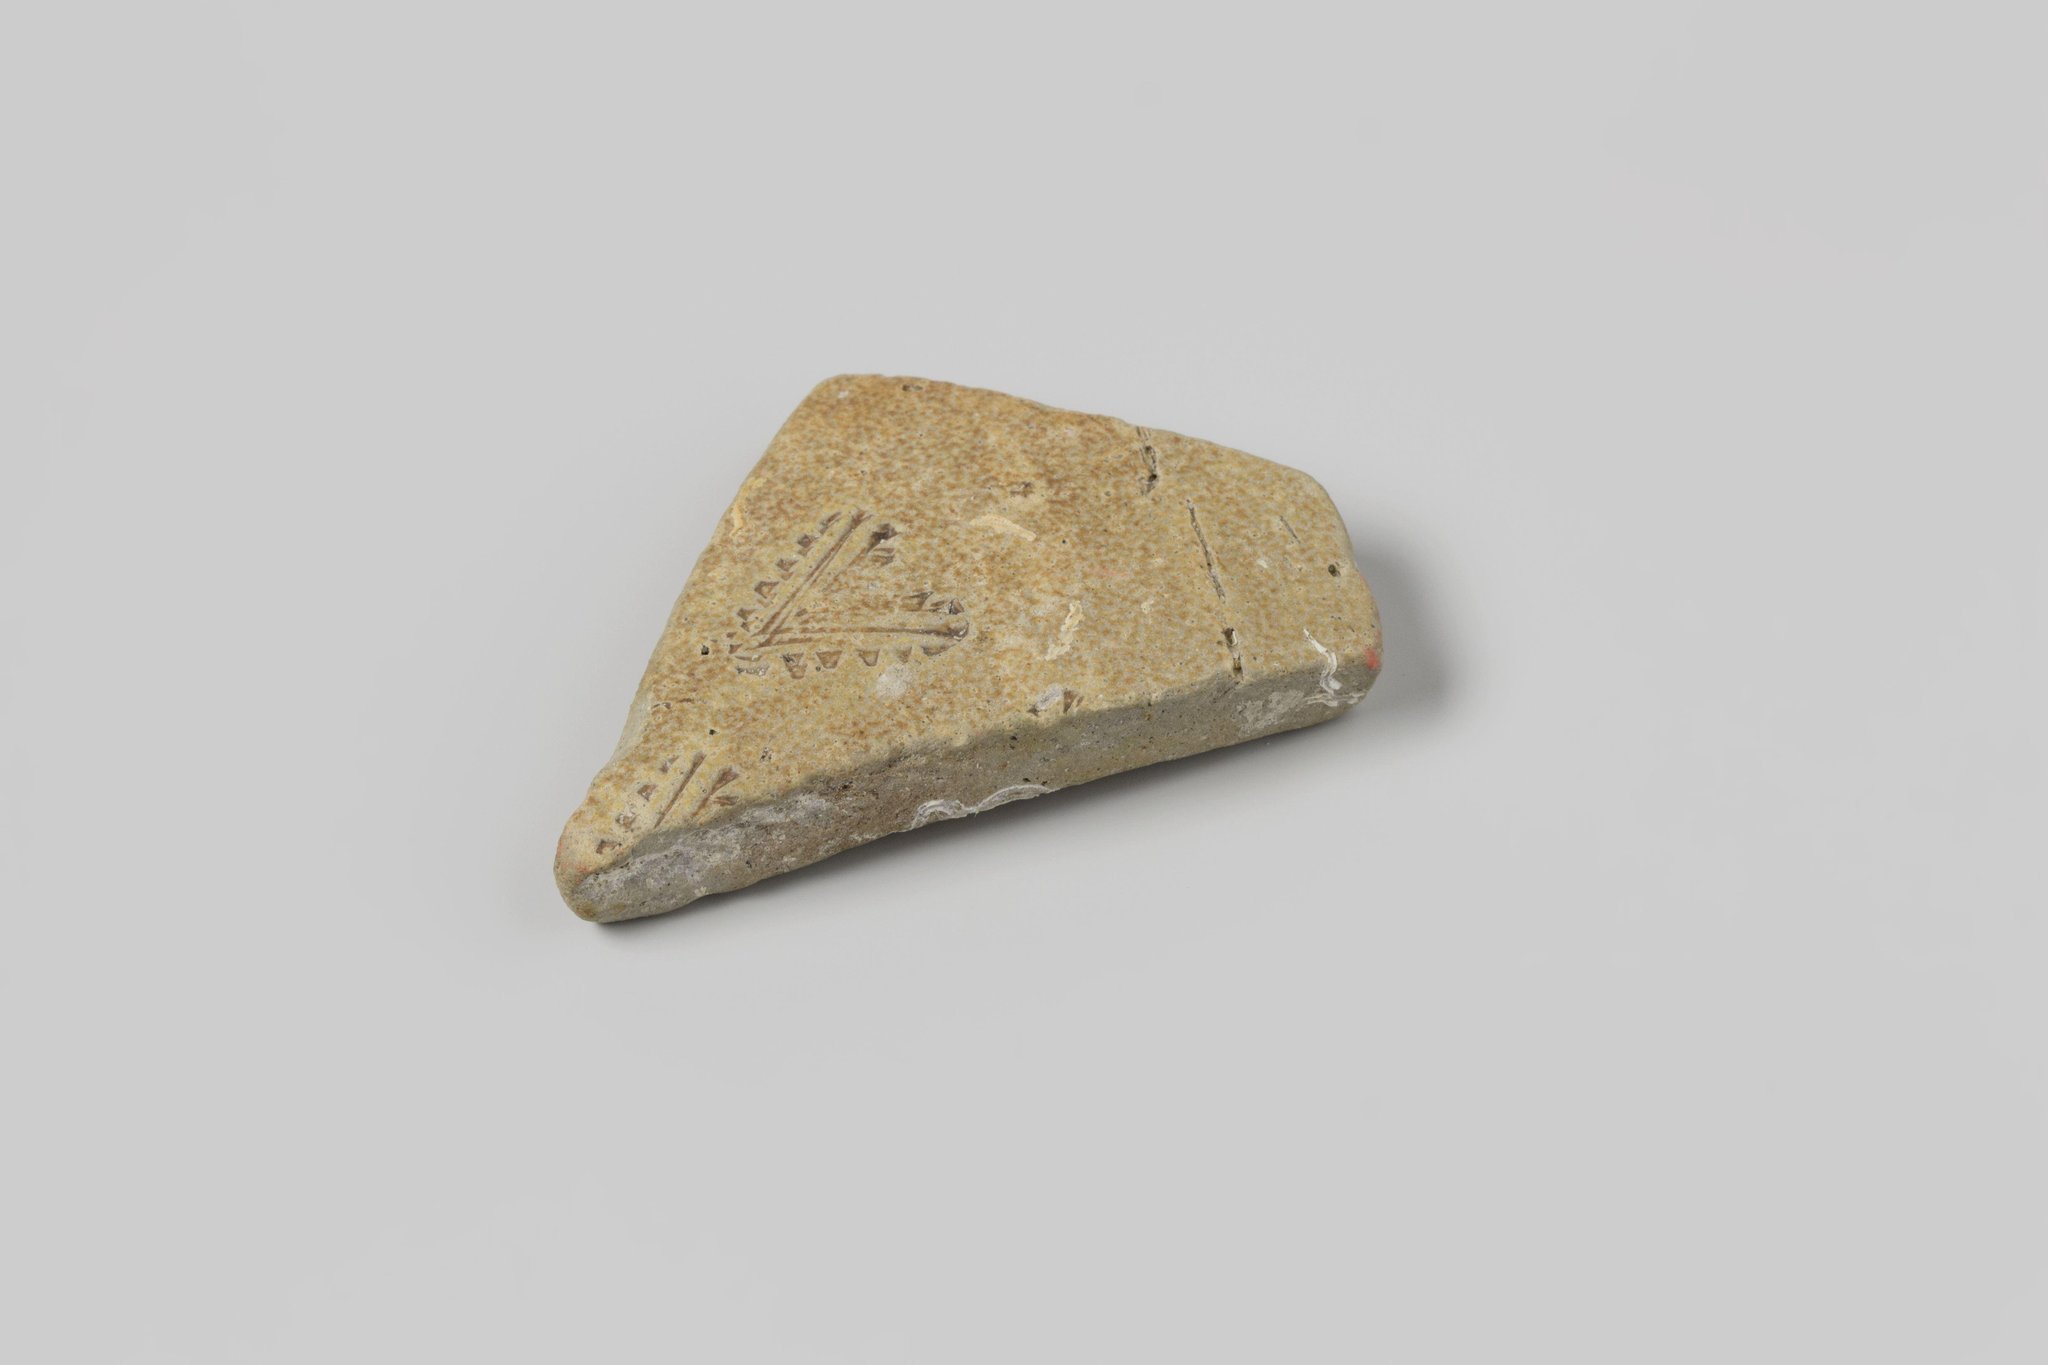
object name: sherd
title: Scherf van een kan uit het wrak van de Oost-Indiëvaarder Hollandia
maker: Anonymous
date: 1700-1743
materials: stoneware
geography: cologne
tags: verenigde oostindische compagnie, hollandia (schip), annet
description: Stoneware, Rhenish, Frechen-ware, jug; fragm of body with V-shaped stamp.